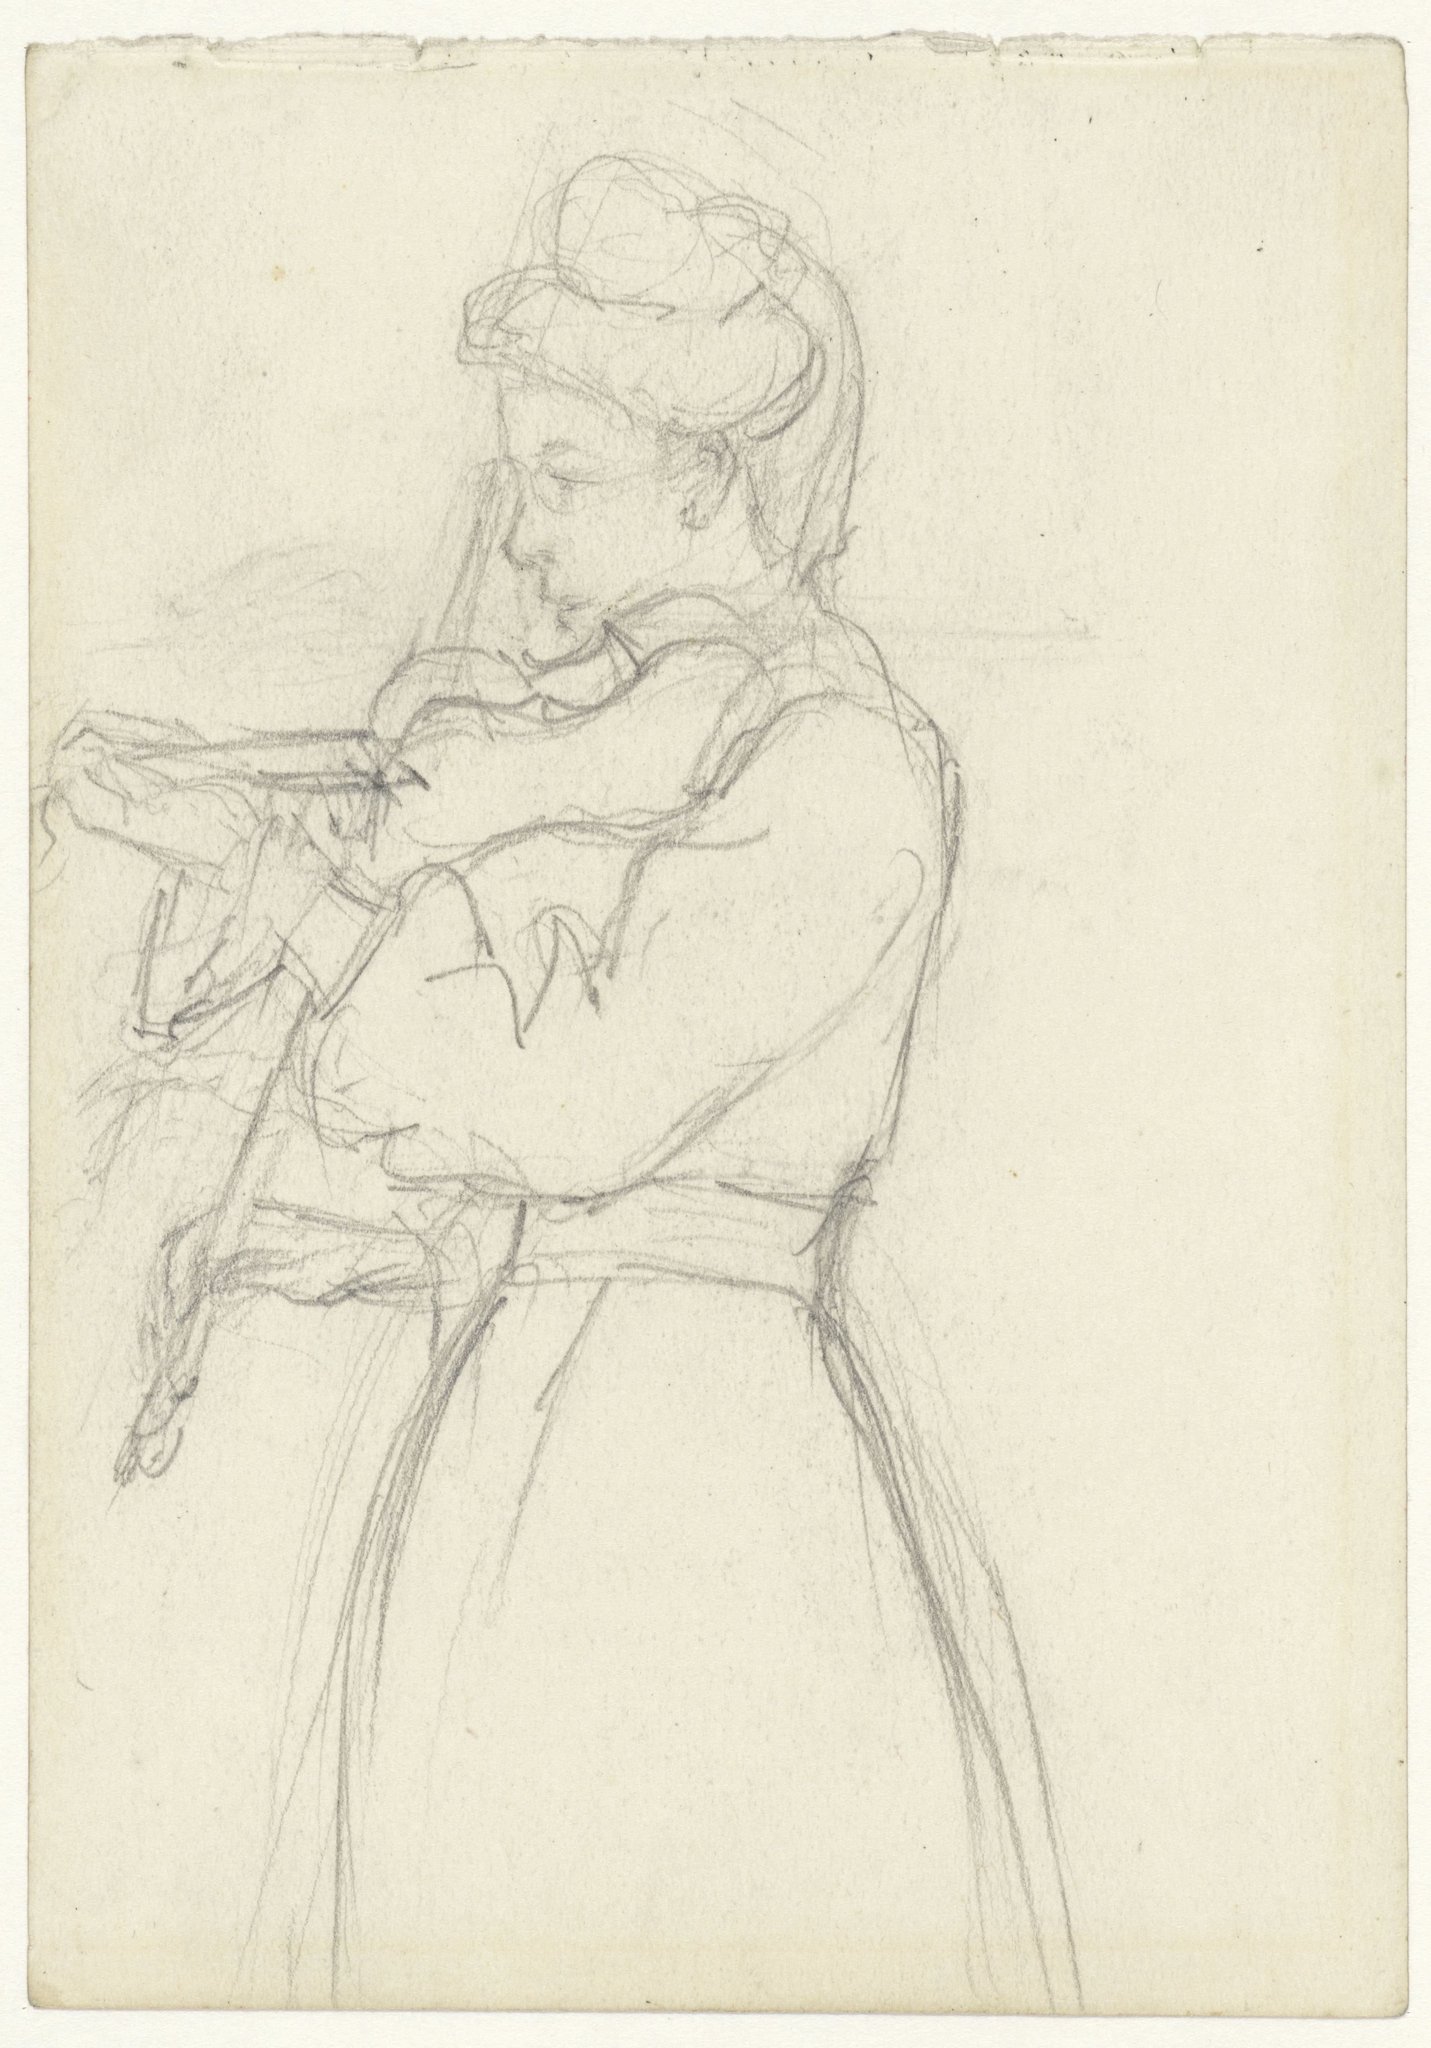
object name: drawing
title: Vioolspelende vrouw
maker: jozef israëls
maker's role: draughtsman, painter, print maker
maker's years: 1824-1911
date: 1834-1911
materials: paper, pencil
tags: one person playing string instrument (bowed), violin, fiddle